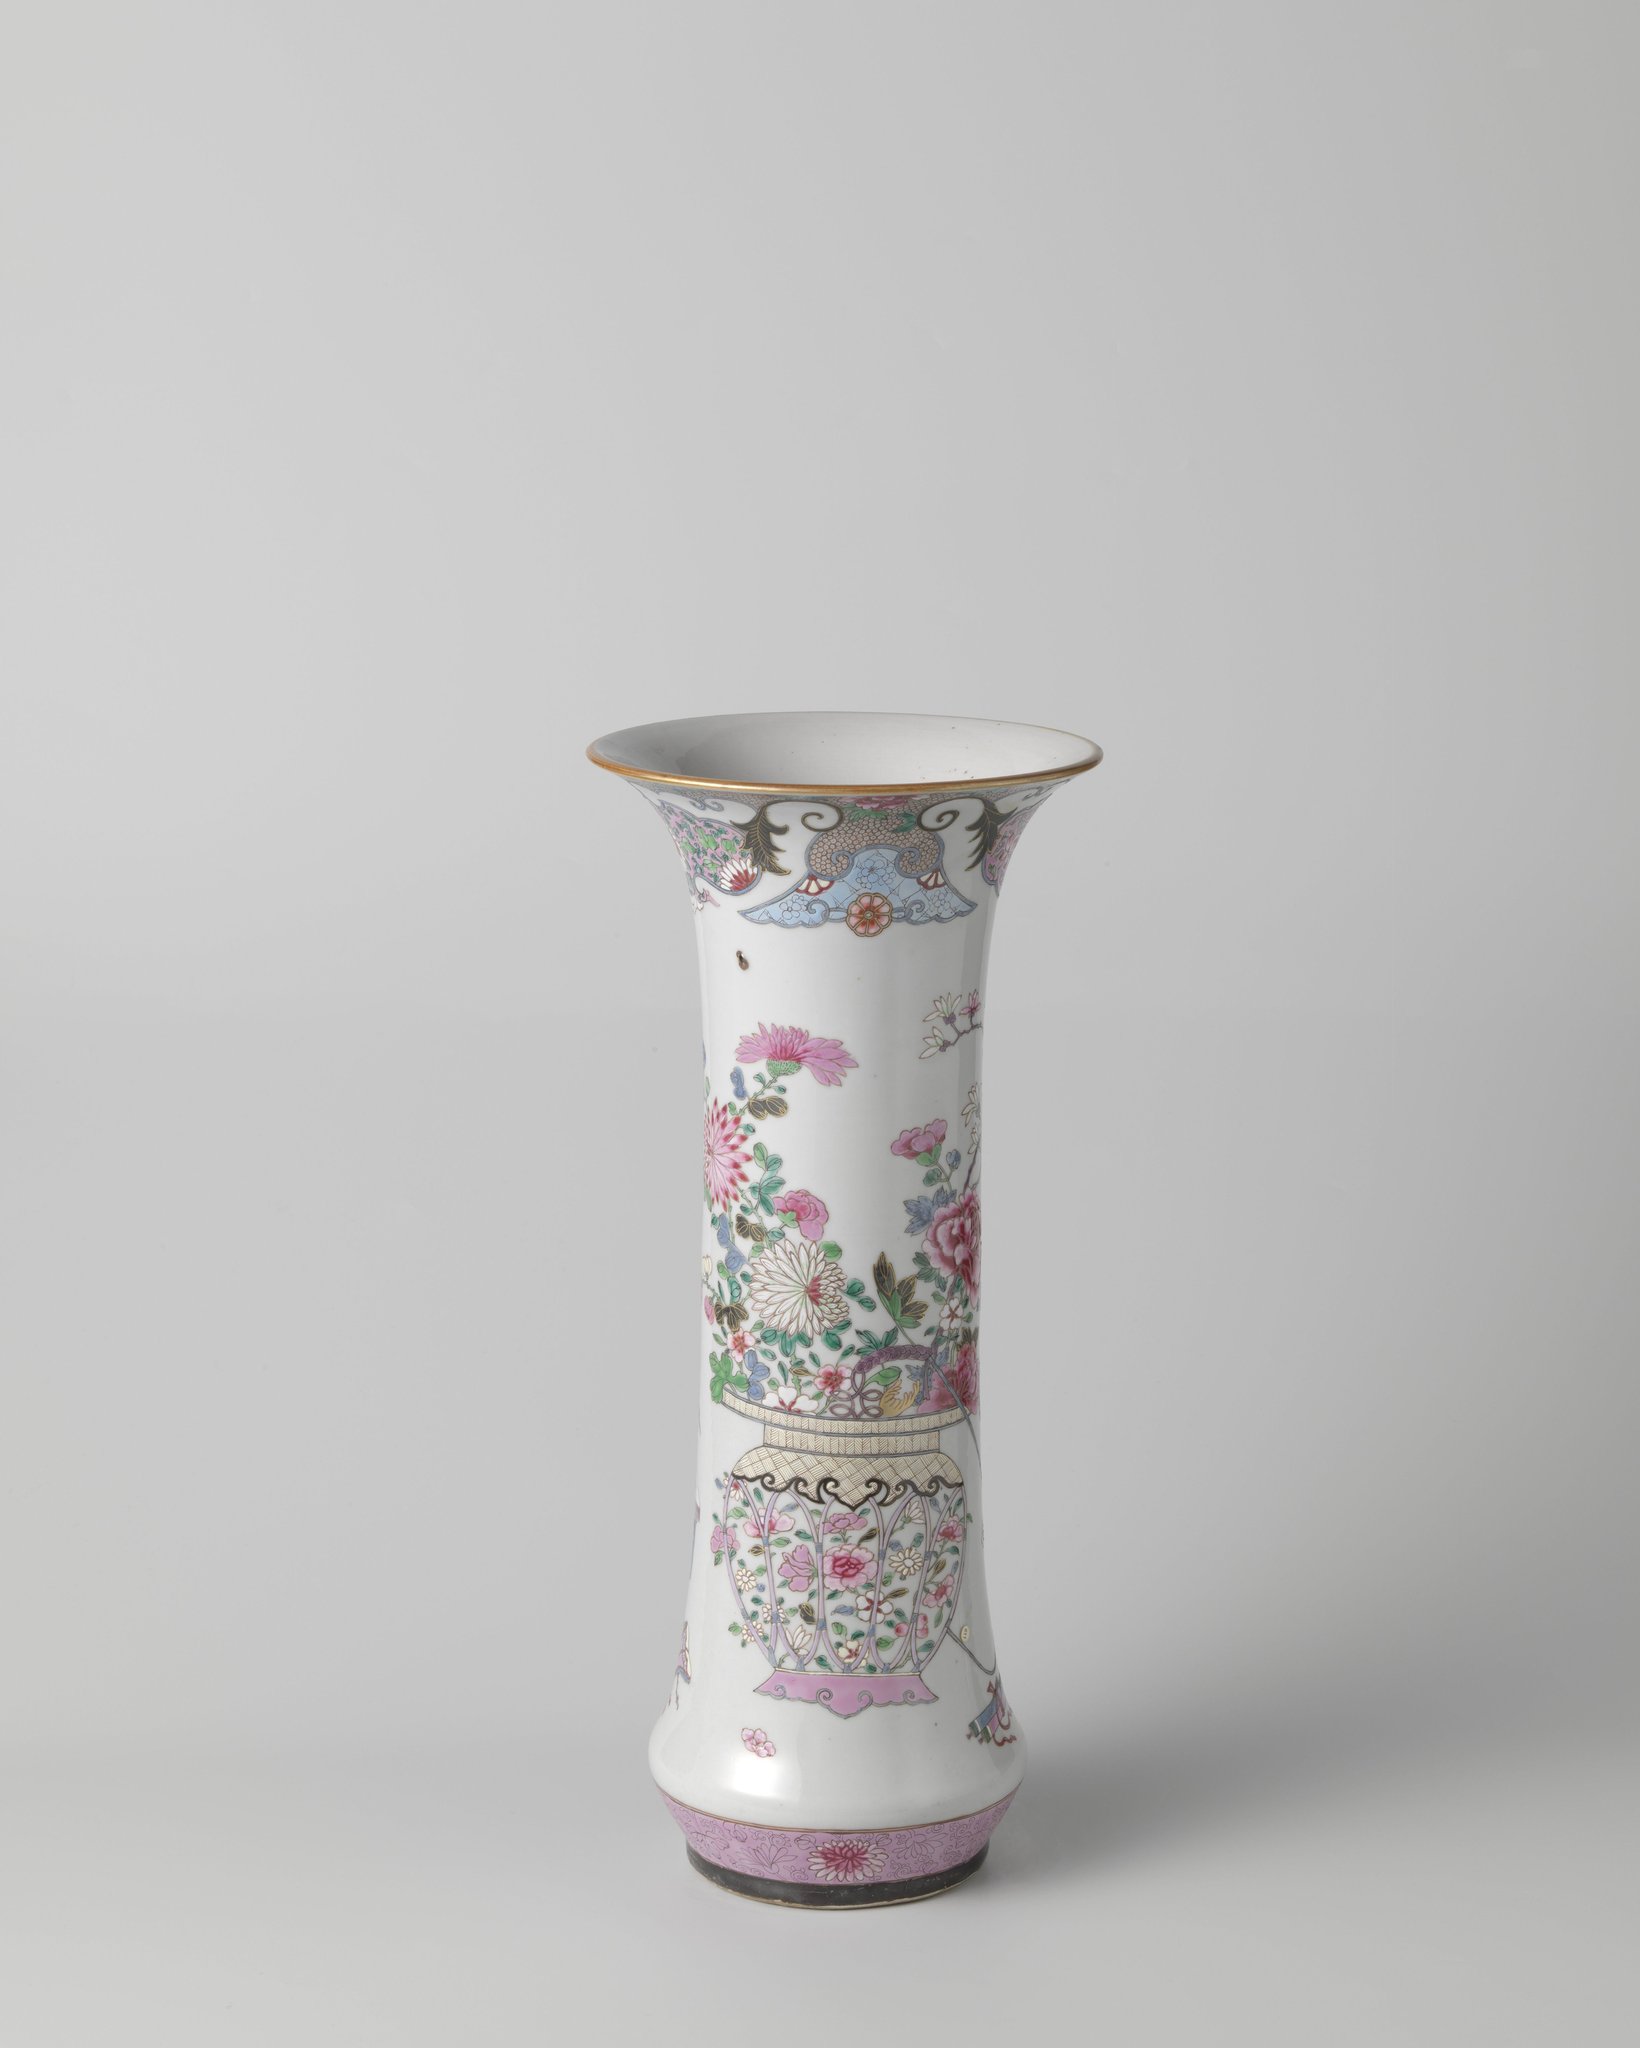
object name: vase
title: Trumpet-shaped beakervase with flower baskets and auspicious symbols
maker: Anonymous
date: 1850-1899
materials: cobalt, glaze, paint, porcelain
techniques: firing, gilding, turning, vitrification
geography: china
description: Trompetvormige bekervaas van porselein, beschilderd in onderglazuur blauw en op het glazuur in blauw, rood, roze, groen, zwart en goud. Op de wand een opengewerkte hengselmand. De mand is gevuld met bloem- en fruittakken (pioen, chrysant, prunus, vingercitroen, magnolia). De andere zijde met een bloemenvaas met 'crackled ice' op een lage tafel. De vaas is omgeven door geluksvoorwerpen (tafel met boeken, een qin en objecten van een geleerde, ruyi-scepter, waaier, wierookbrander en rollen). Op de buitenrand een onregelmatige band met pioenranken op 'kikkerdril', bladranken, chrysantranken, bloemrozetten en perzikbloesem 'crackled ice'. Rond de voet een band met chrysantranken. Decoratie wijkt af van de andere delen van het kaststel. Bekervaas is onderdeel van kaststel AK-RBK-15919. Famille rose.